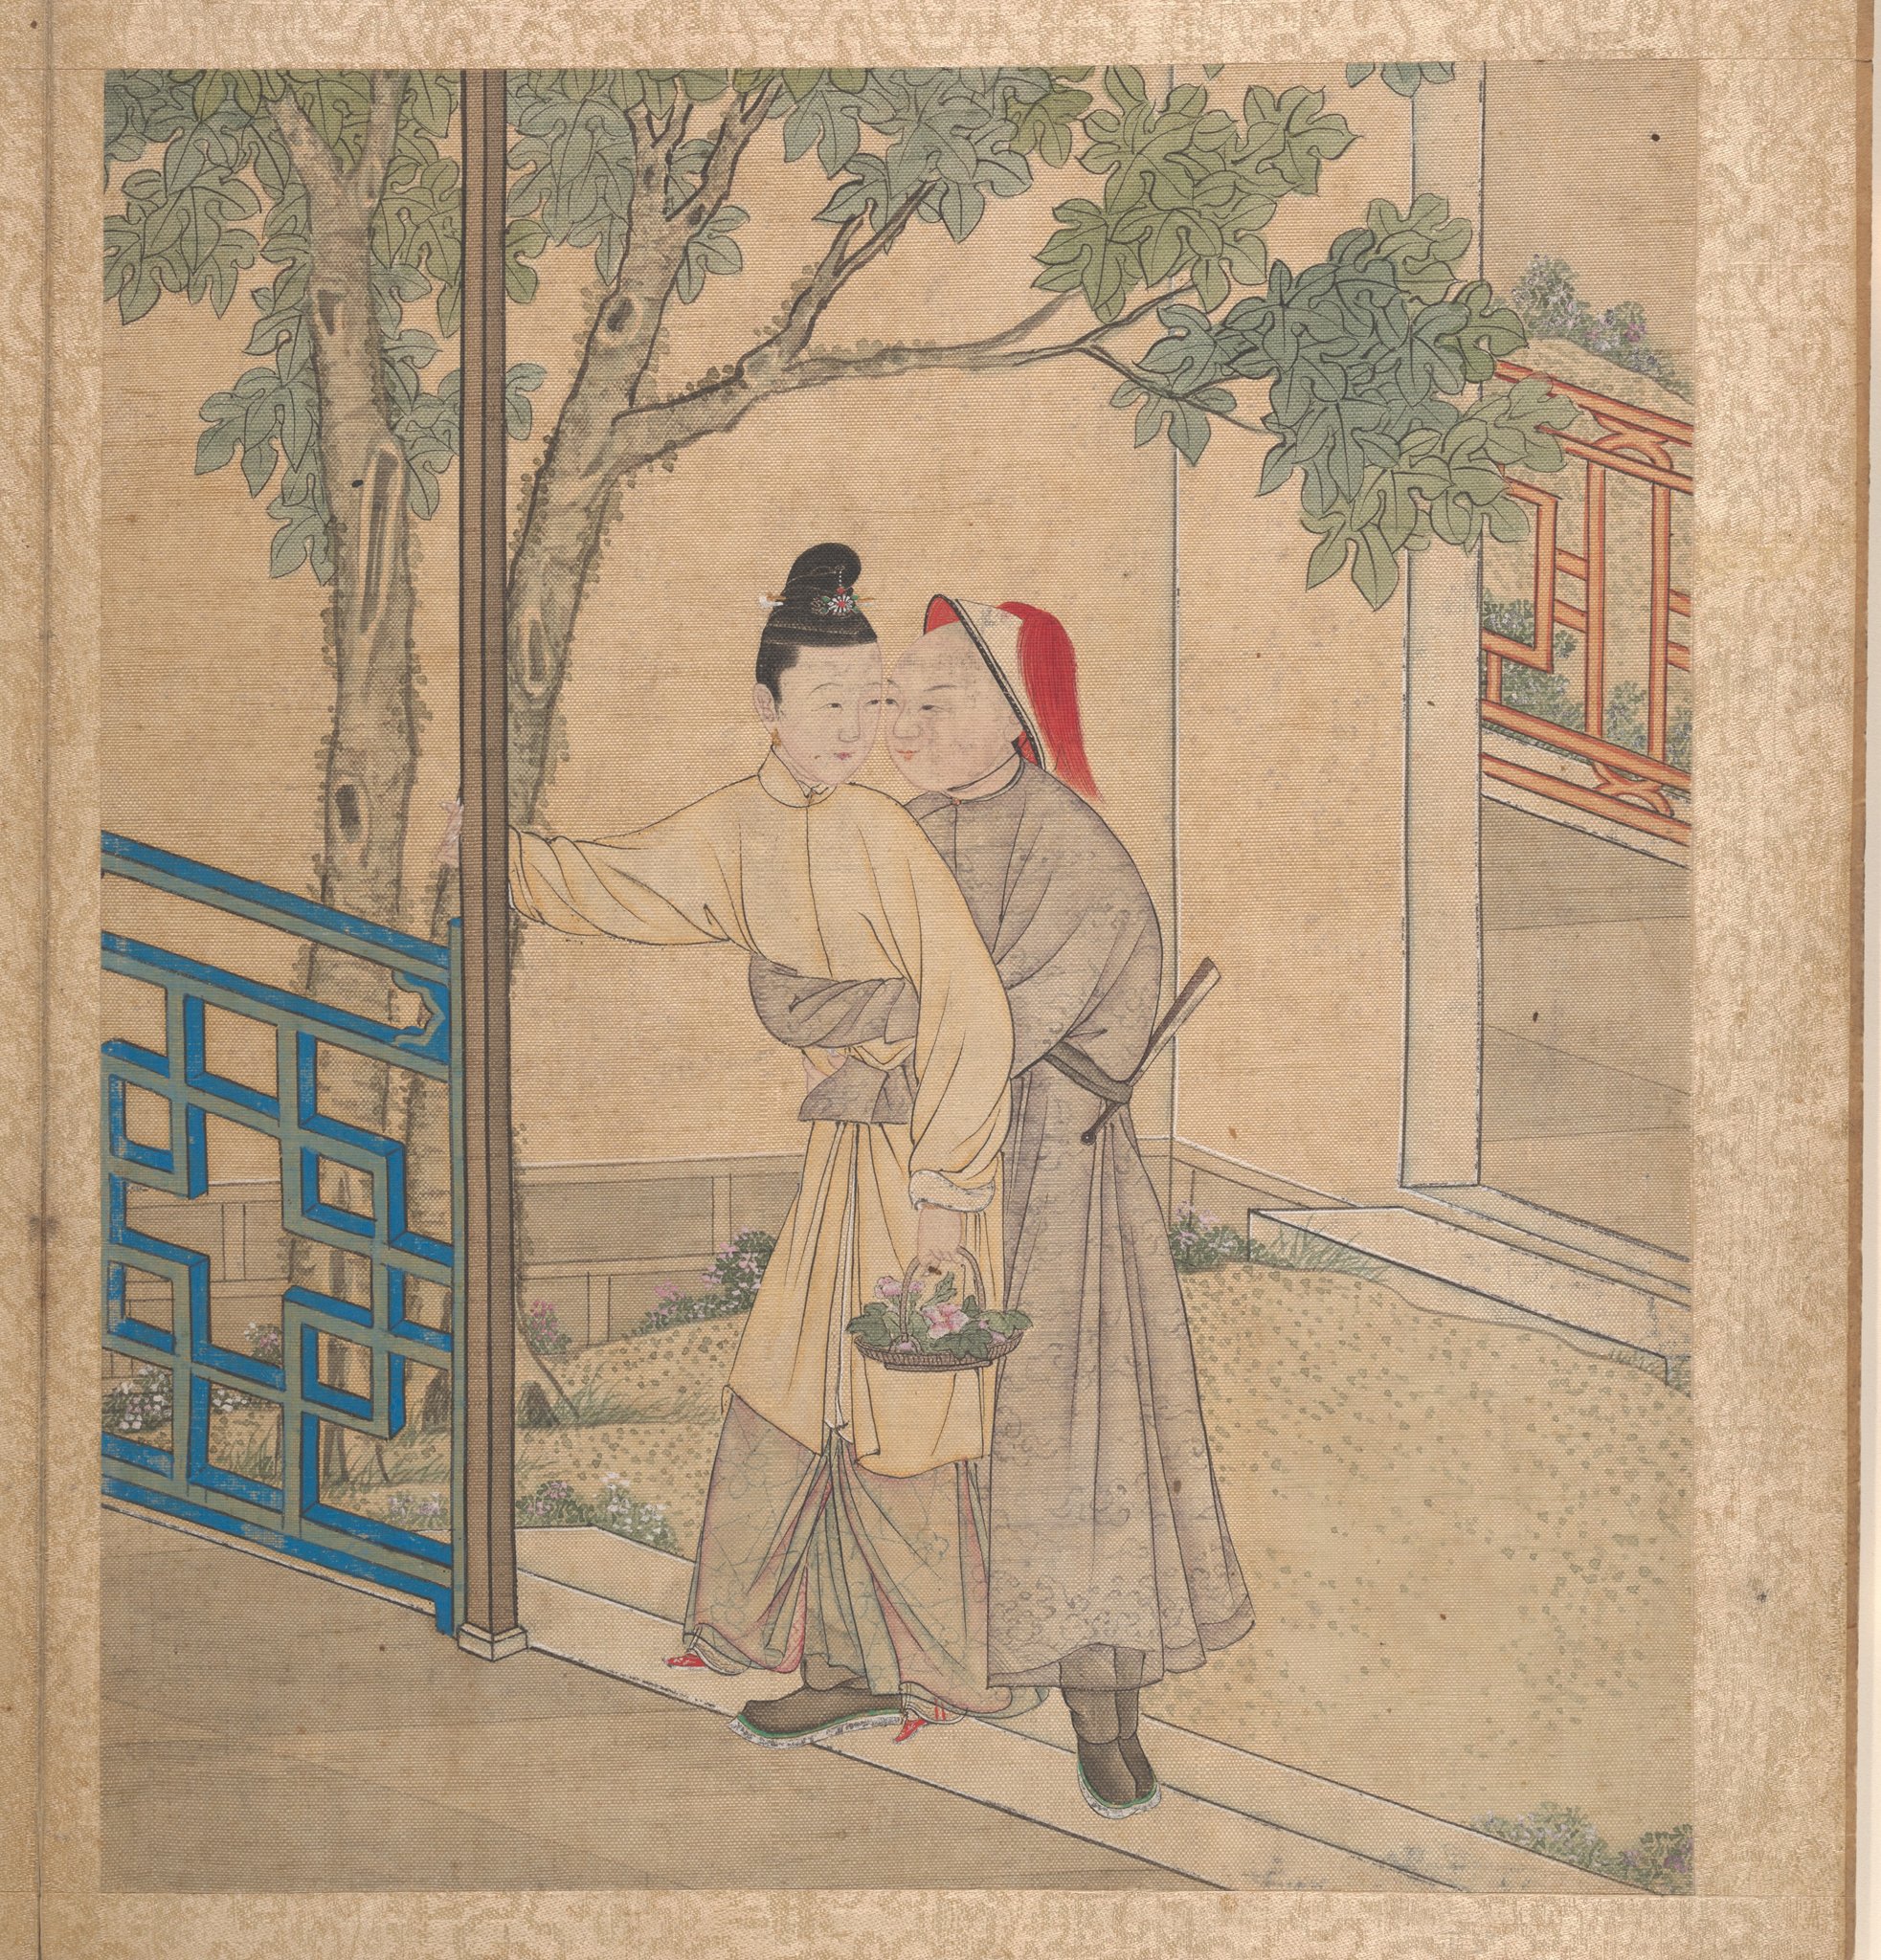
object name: album leaf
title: Spring Pictures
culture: chinese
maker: unidentified artist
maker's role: artist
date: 1644-1911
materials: ink, silk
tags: couples,men,women